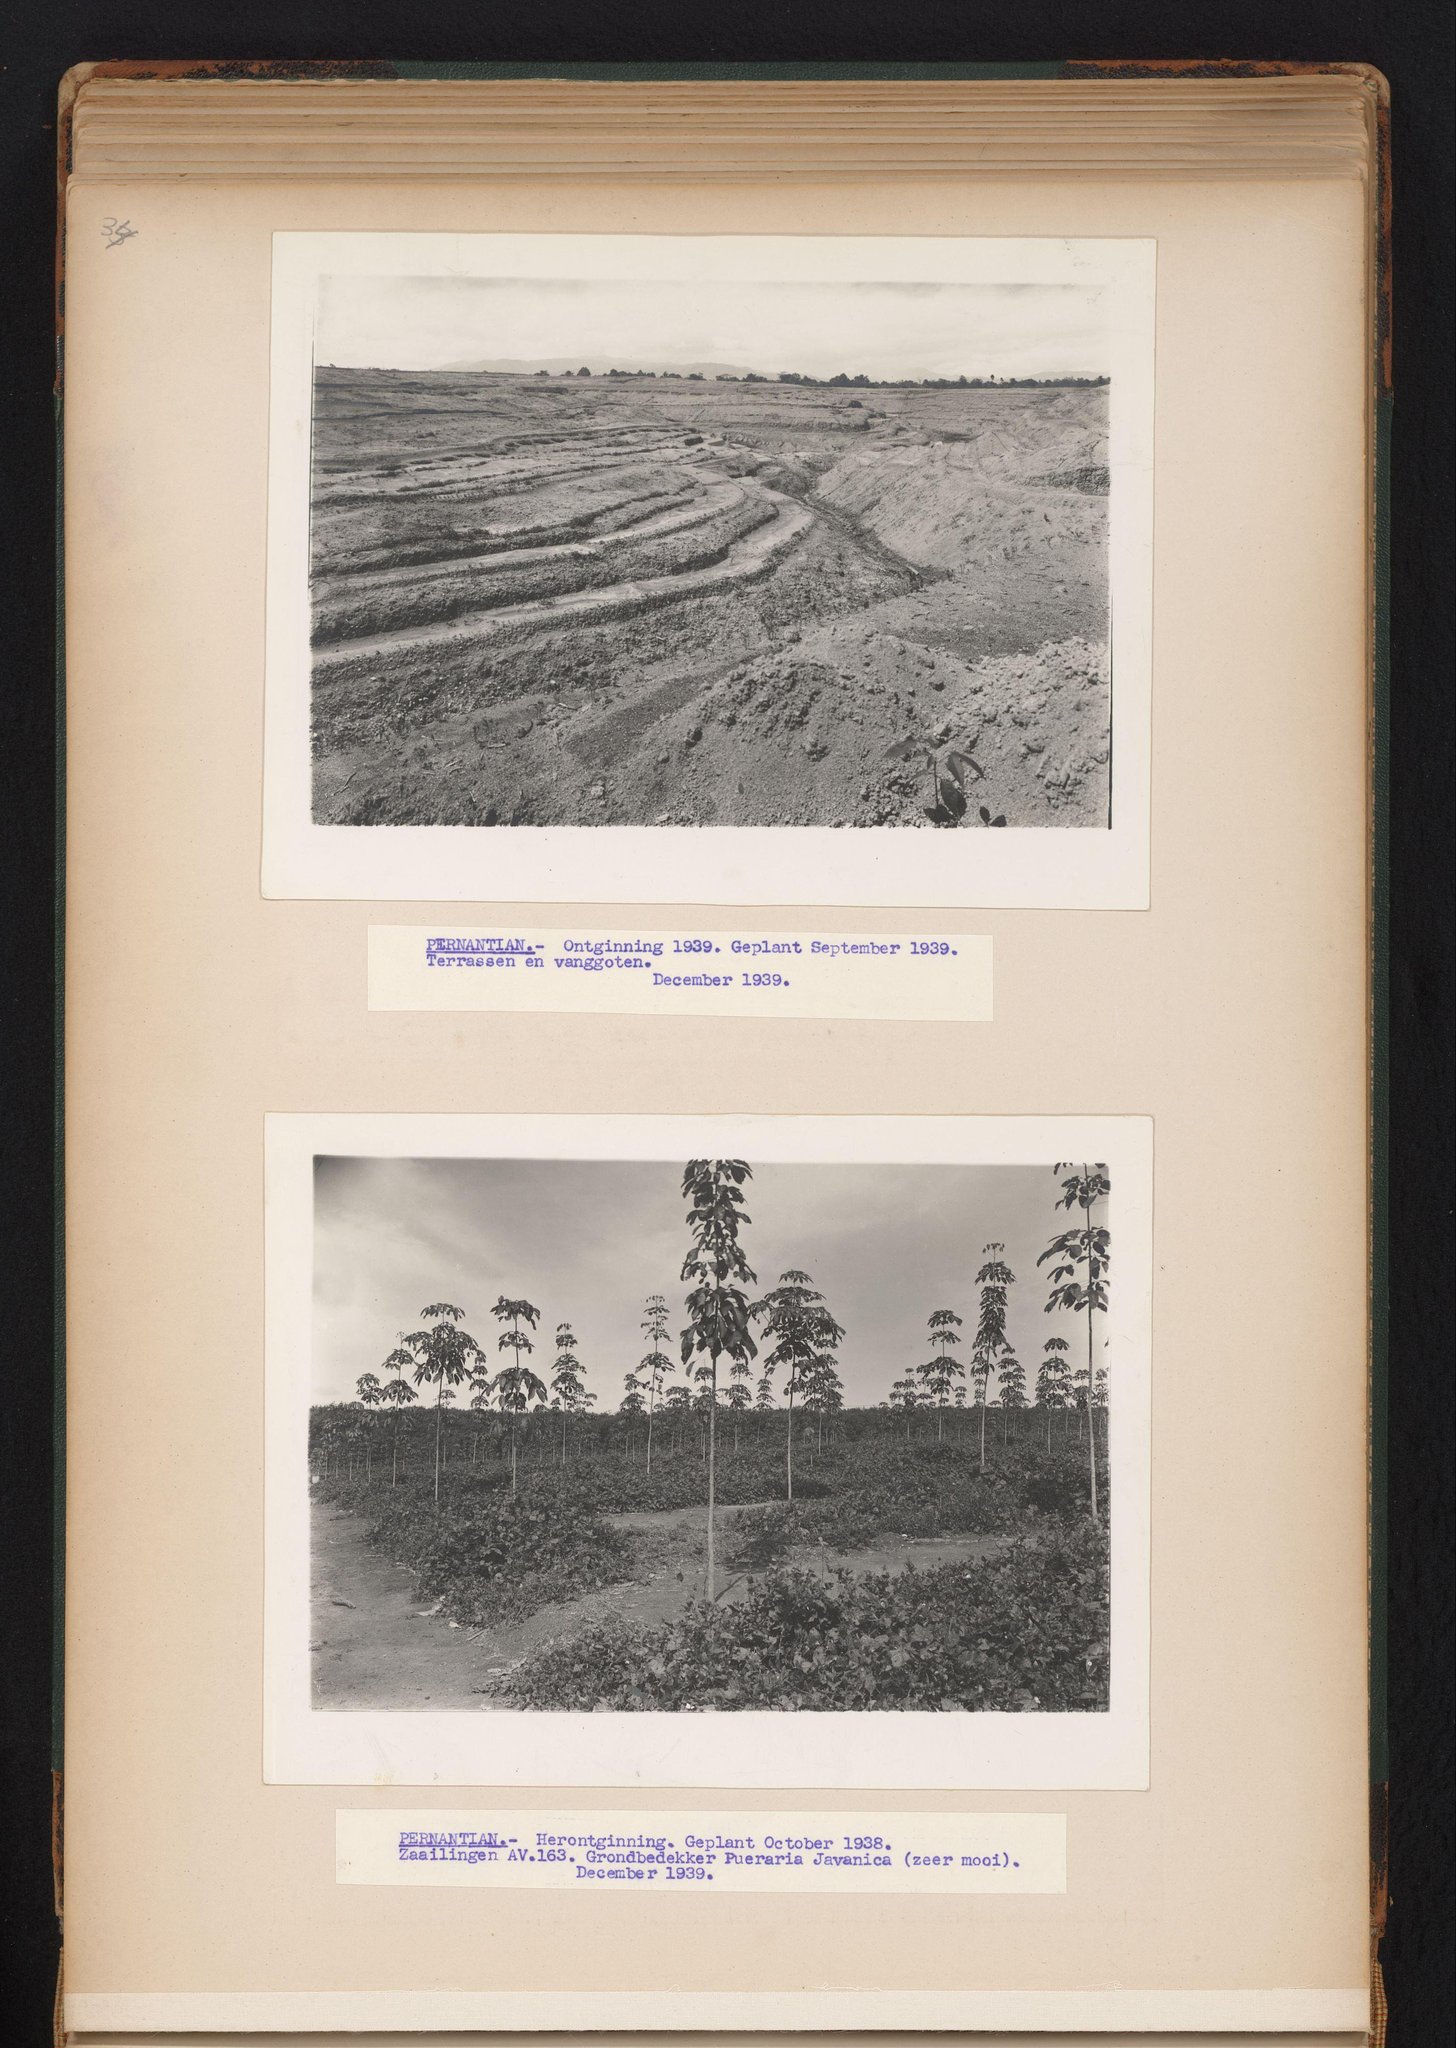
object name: photograph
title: Ontginning op Pernantian, 1939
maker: Anonymous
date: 1912-1939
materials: cardboard, photographic support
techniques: gelatin silver print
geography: sumatra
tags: plantation, (non-fruit) products of plants or trees: rubber, sumatra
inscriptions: inscription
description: Blad met twee foto's van akkers met rubberbomen op Pernantian, december 1939. Met etiketten met onderschriften onder de foto's. Onderdeel van het fotoalbum over de plantages Pernantian en Brussel van de Sumatra Caoutchouc Maatschappij op de Oostkust van Sumatra in de jaren 1935-1939.